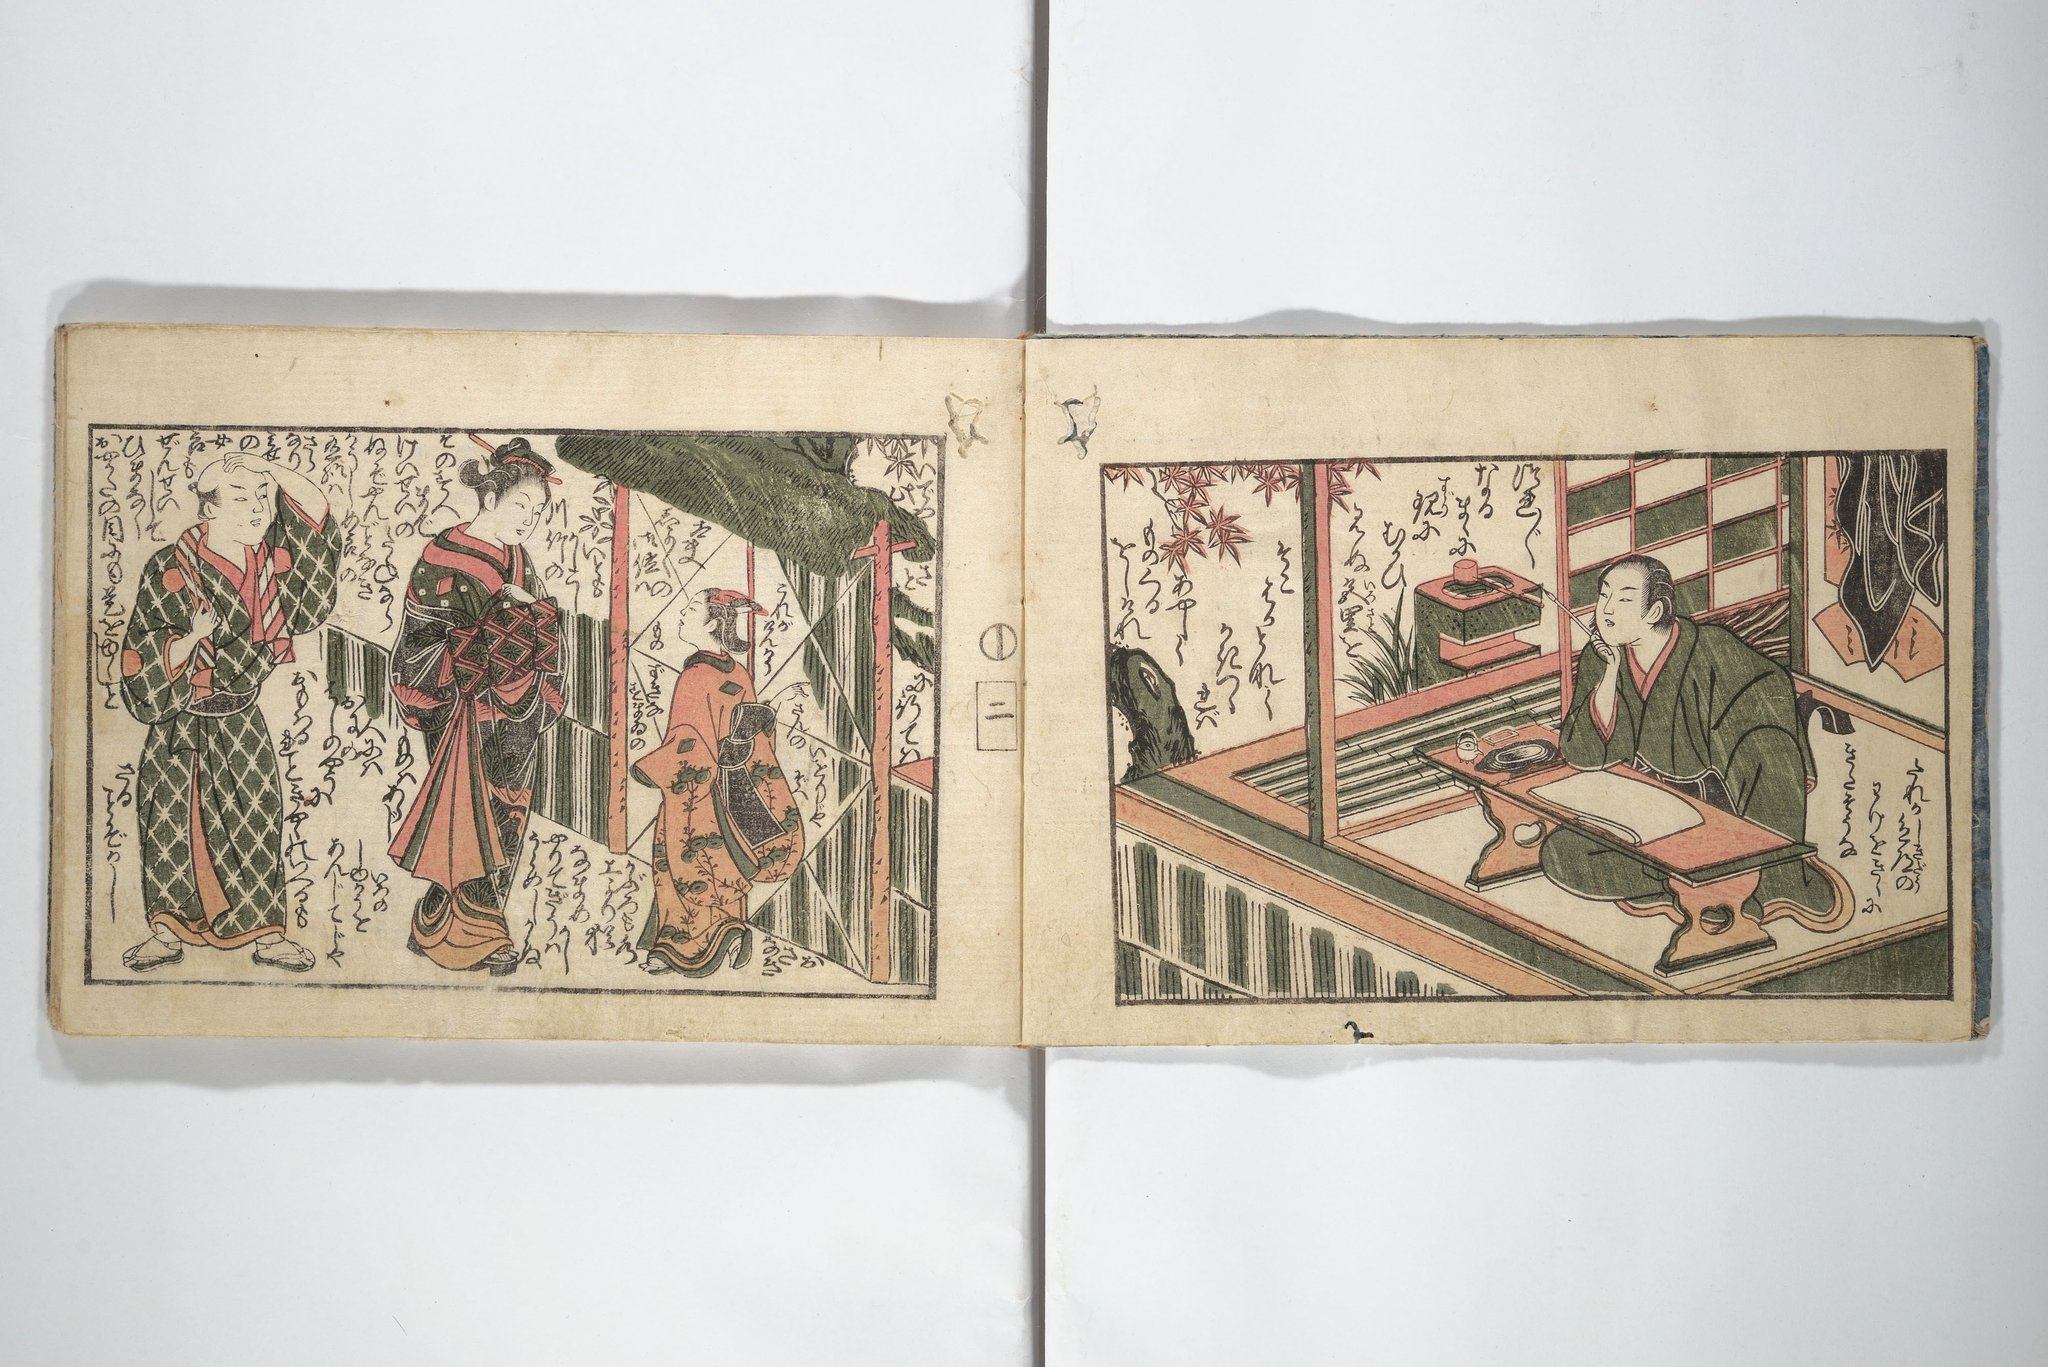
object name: illustrated book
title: Love Poses in the Narabi Hills (Nure sugata narabi no oka) 濡姿雙の岡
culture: japanese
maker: okumura masanobu 奥村政信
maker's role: artist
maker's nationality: japanese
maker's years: 1686-1764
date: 1701-1800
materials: ink, paper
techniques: woodblock print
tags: men,women